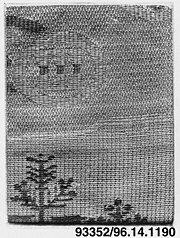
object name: piece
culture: japanese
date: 1701-1900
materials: silk